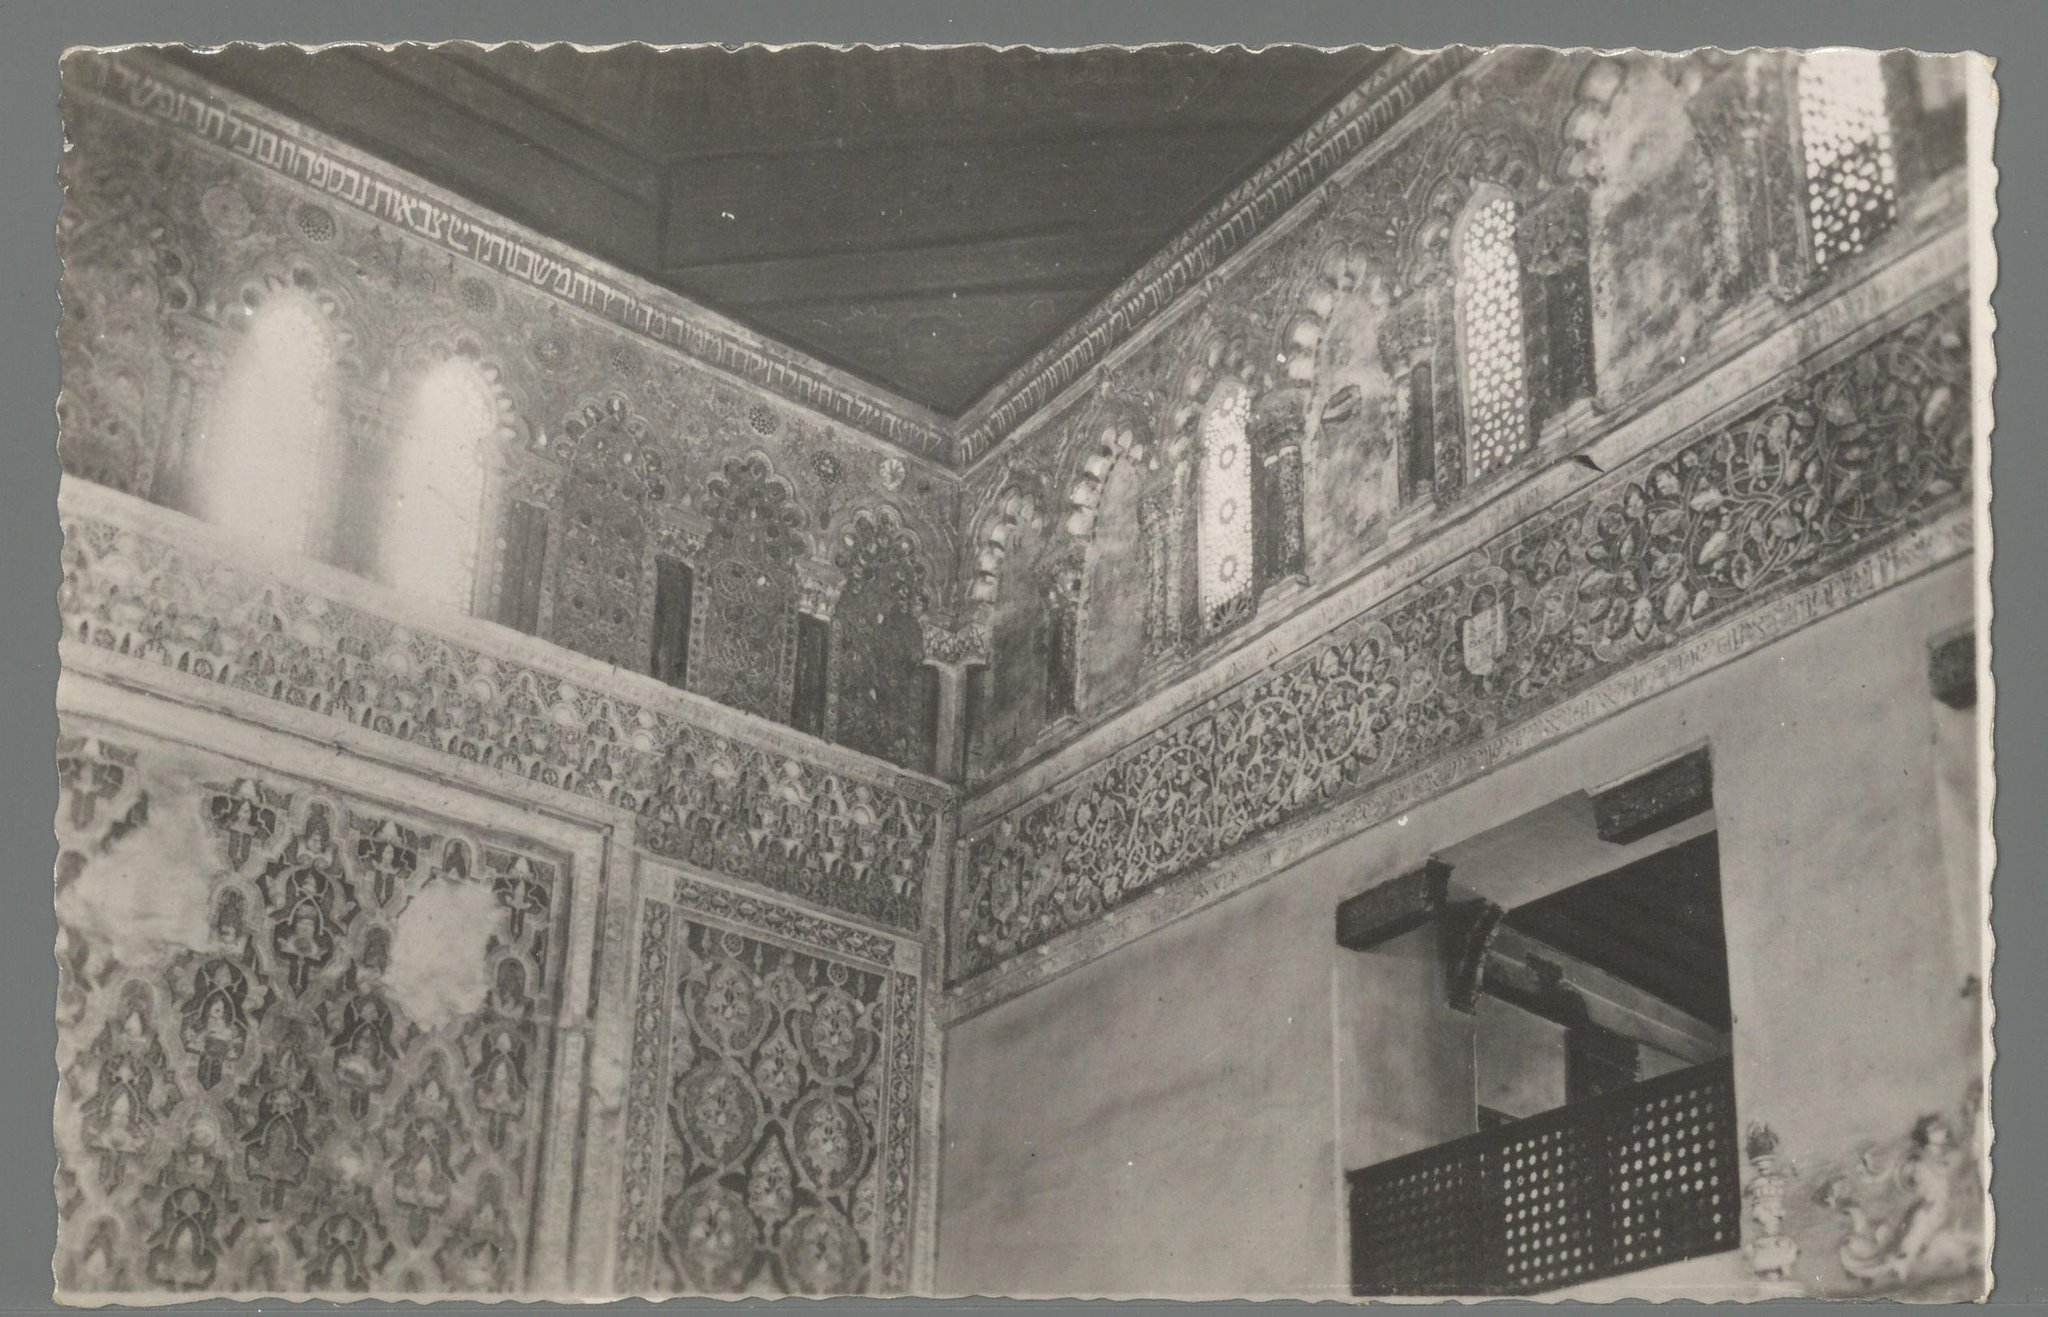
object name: ansichtkaart, prentbriefkaart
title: Toledo. Sinagoga del Tránsito. Detalle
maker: Anonymous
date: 1930-1950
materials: paper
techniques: gelatin silver print, writing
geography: toledo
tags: the synagogue (as building and place of worship ~ jewish religion)